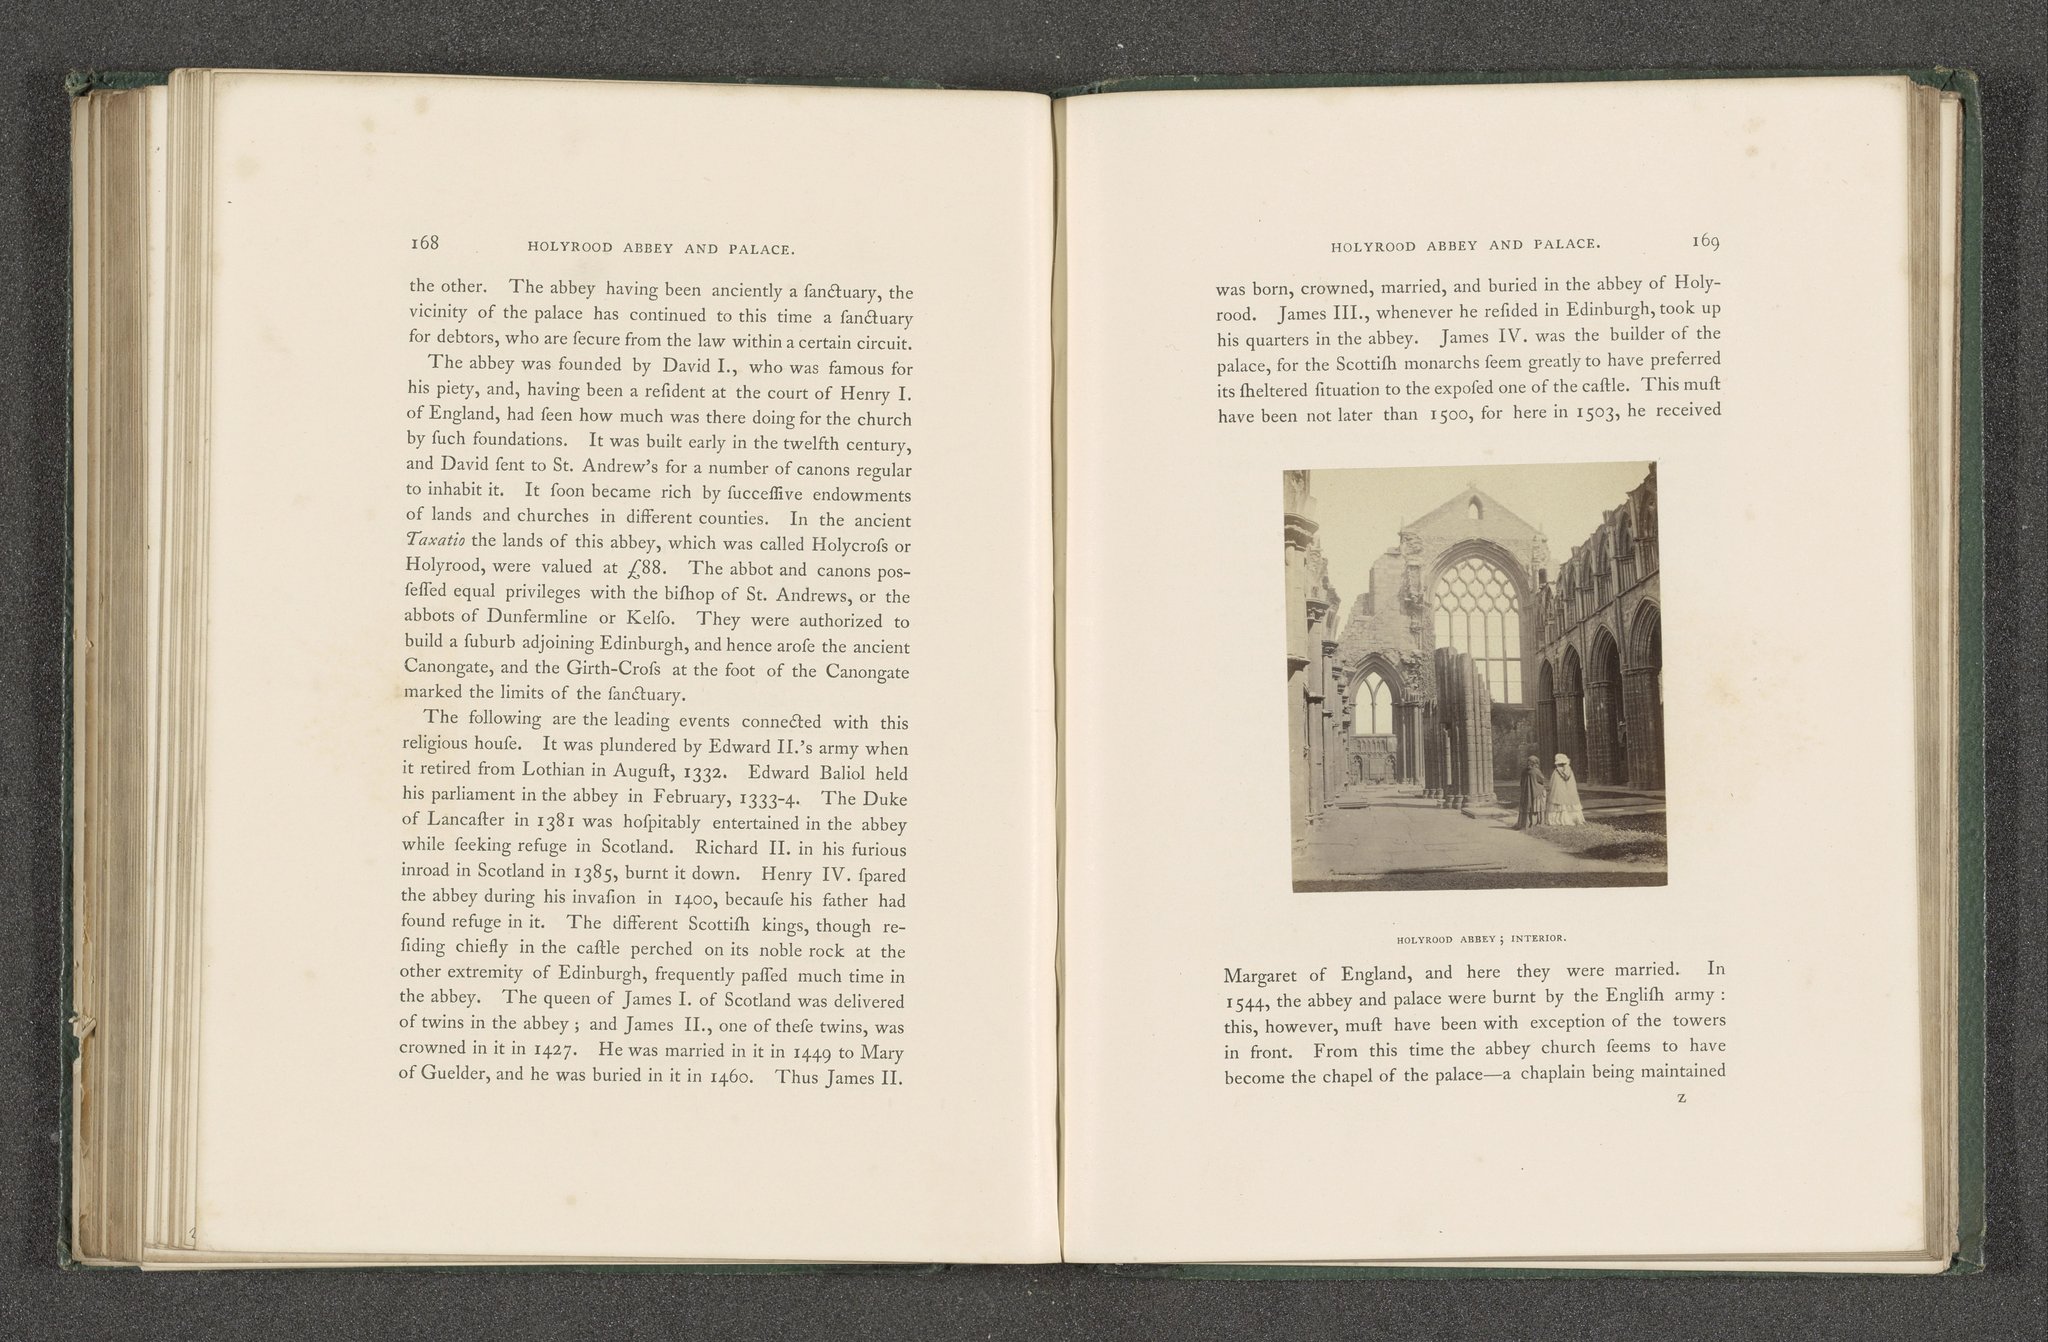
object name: page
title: Holyrood Abbey ; Interior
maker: george washington wilson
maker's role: publisher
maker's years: 1823-1893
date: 1852-1862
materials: photographic support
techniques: albumen print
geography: holyrood abbey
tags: ruin of church, monastery, etc.